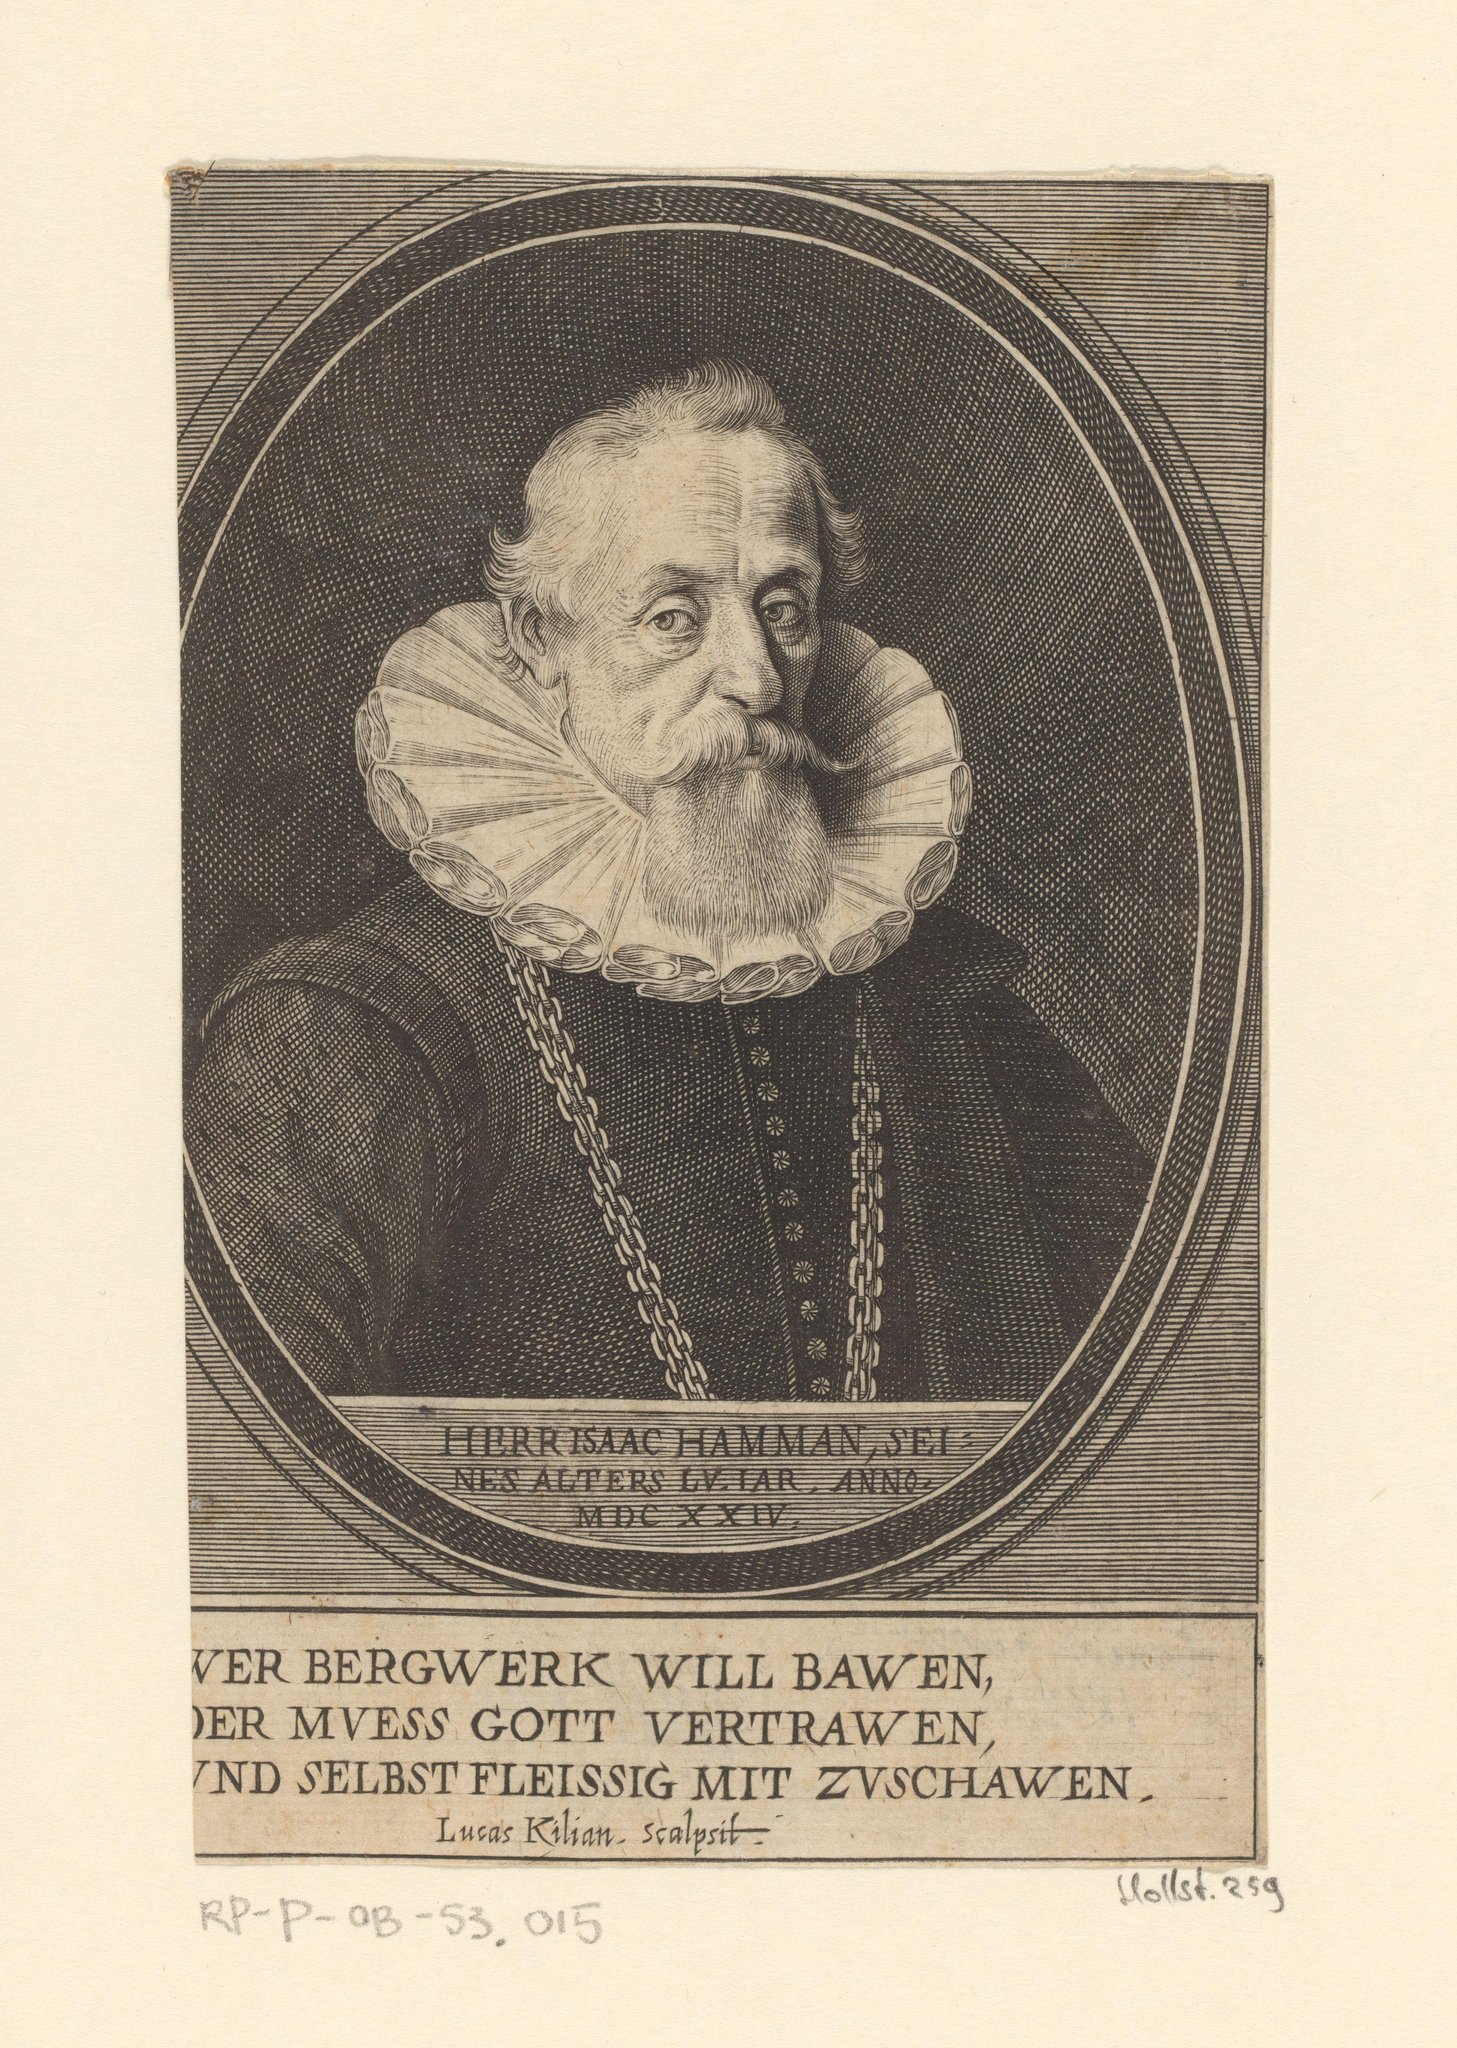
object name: print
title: Portret van Isaac Hamman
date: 1604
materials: paper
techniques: engraving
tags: engineering (+ portrait of scholar, scientist), historical persons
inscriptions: collector's mark: Lugt 2228